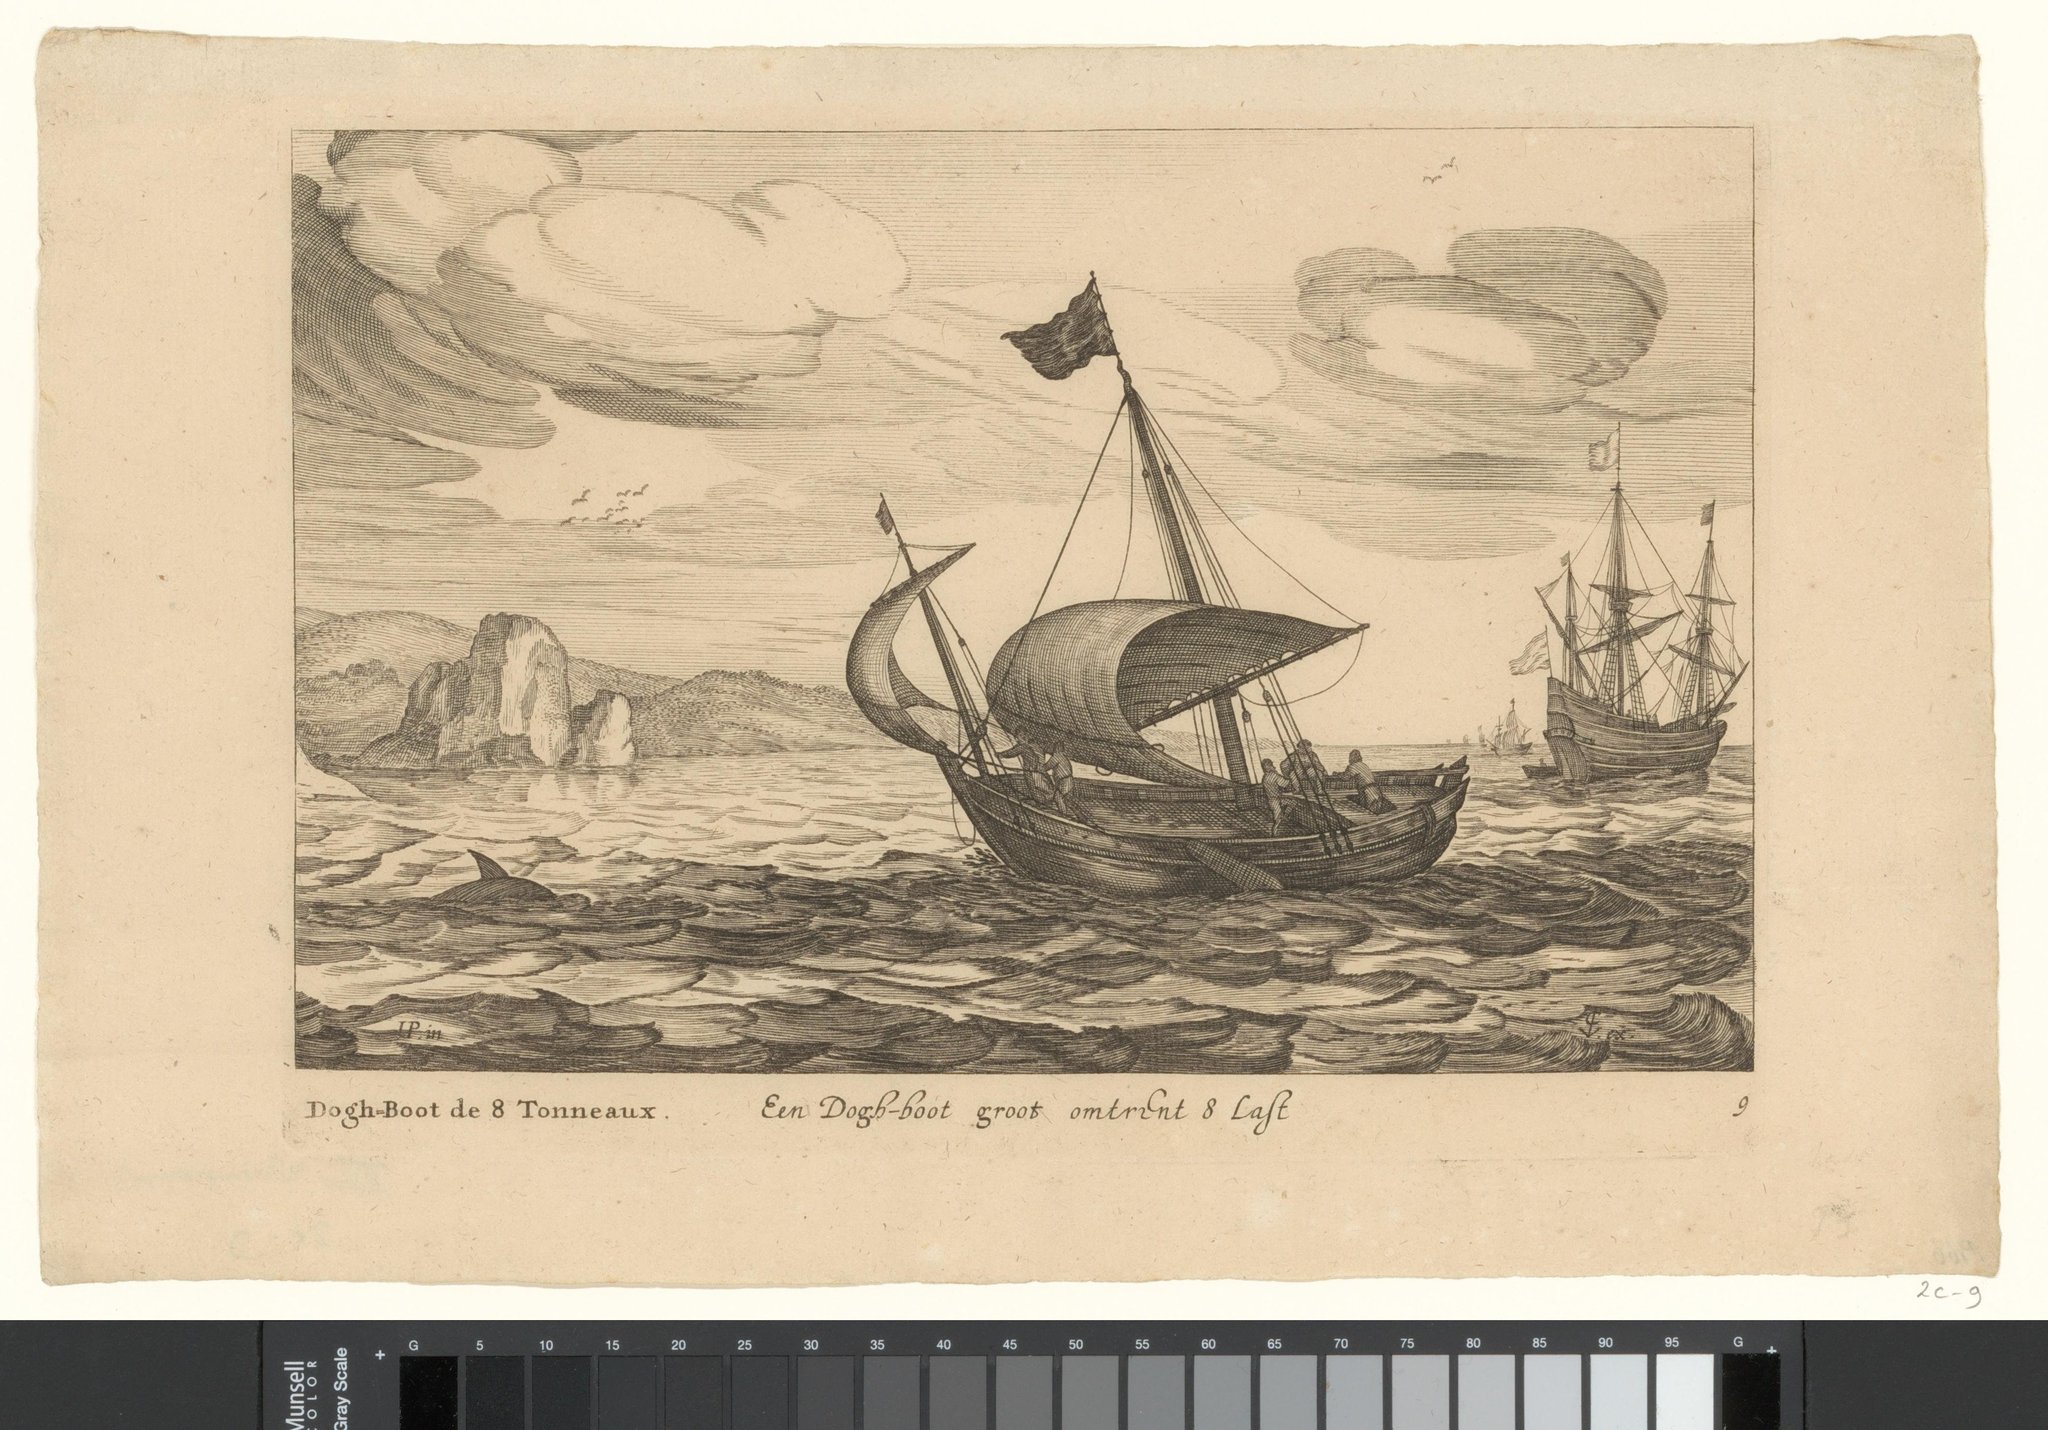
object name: print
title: Diverse navires dont on se sert dans les Provinces Unies / Icones variarum navium Hollandicarum quarum usus maximè in aquis interioribus regionis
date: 1717-1779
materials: paper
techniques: engraving, etching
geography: amsterdam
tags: sailing-ship, sailing-boat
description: Een dogger of dogboot op het water. Rechtsonder genummerd: 9. Onderwerpsrubrieken binnen de Atlas Zeden en Gewoonten: Handel, Nijverheid en Verkeer, Scheepsvaart.